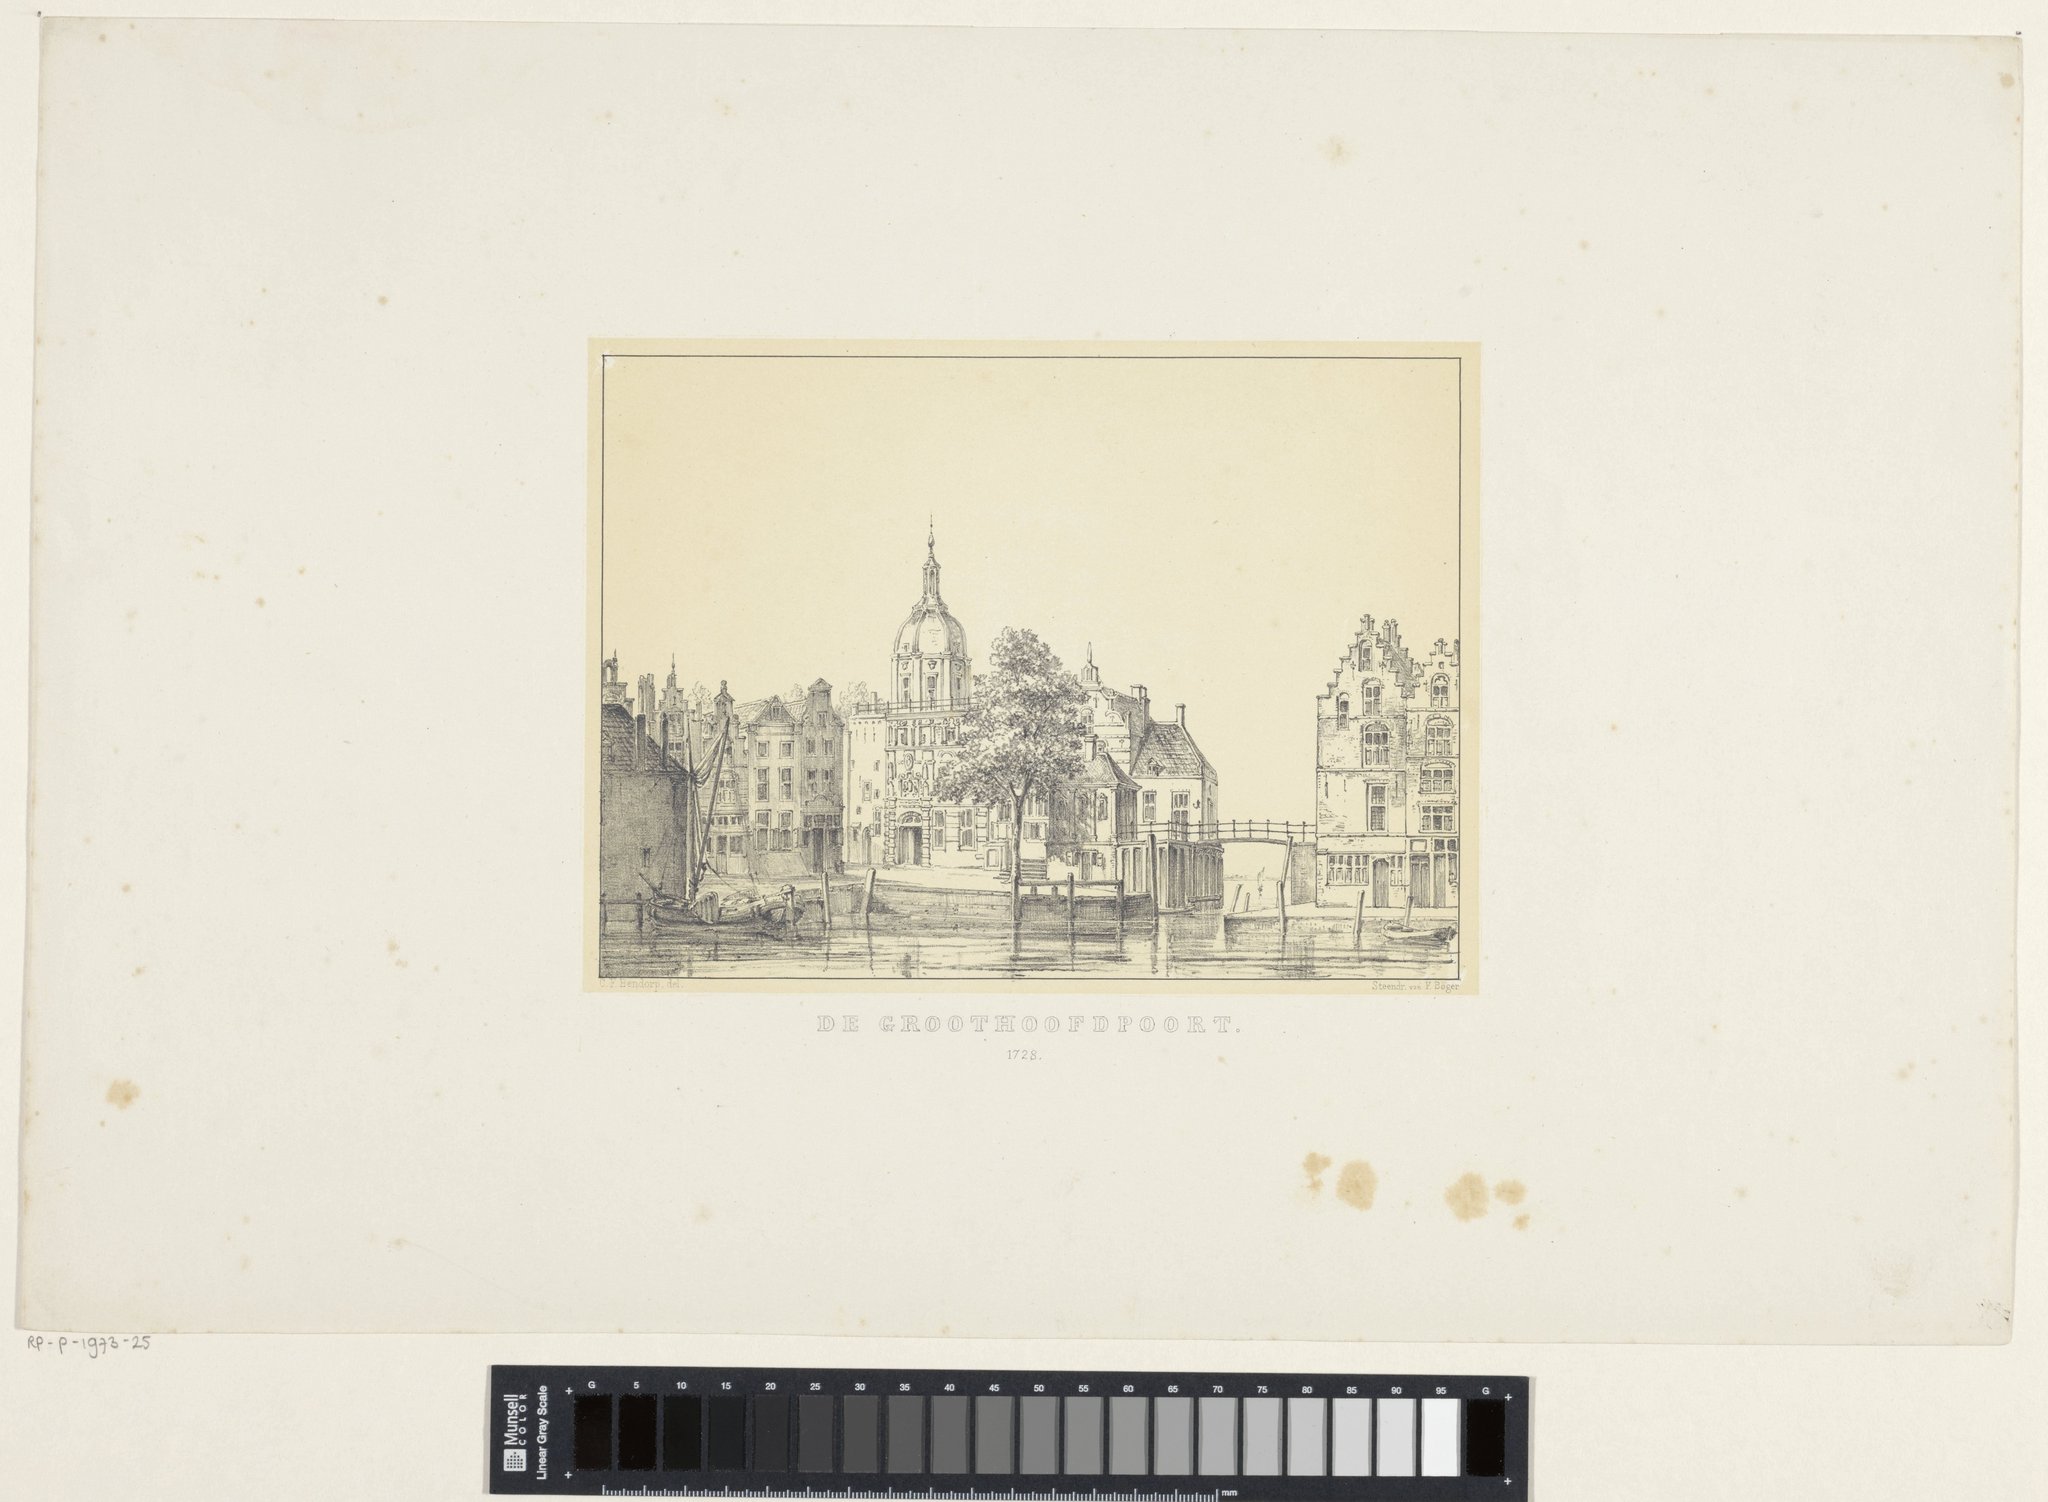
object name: print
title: Groothoofdspoort dordrecht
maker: carel frederik bendorp (ii)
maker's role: draughtsman, painter, print maker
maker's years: 1819-1897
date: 1872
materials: paper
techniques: tone lithography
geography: dordrecht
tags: sailing-ship, sailing-boat, gate, entrance, bridge in city across river, canal, etc., dordrecht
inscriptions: collector's mark: Lugt 2228, collector's mark: Lugt 2760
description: De poort is vanaf de Oude Maas te zien. Links ligt een boot bij de kade. Onder de afbeelding het jaartal 1728.